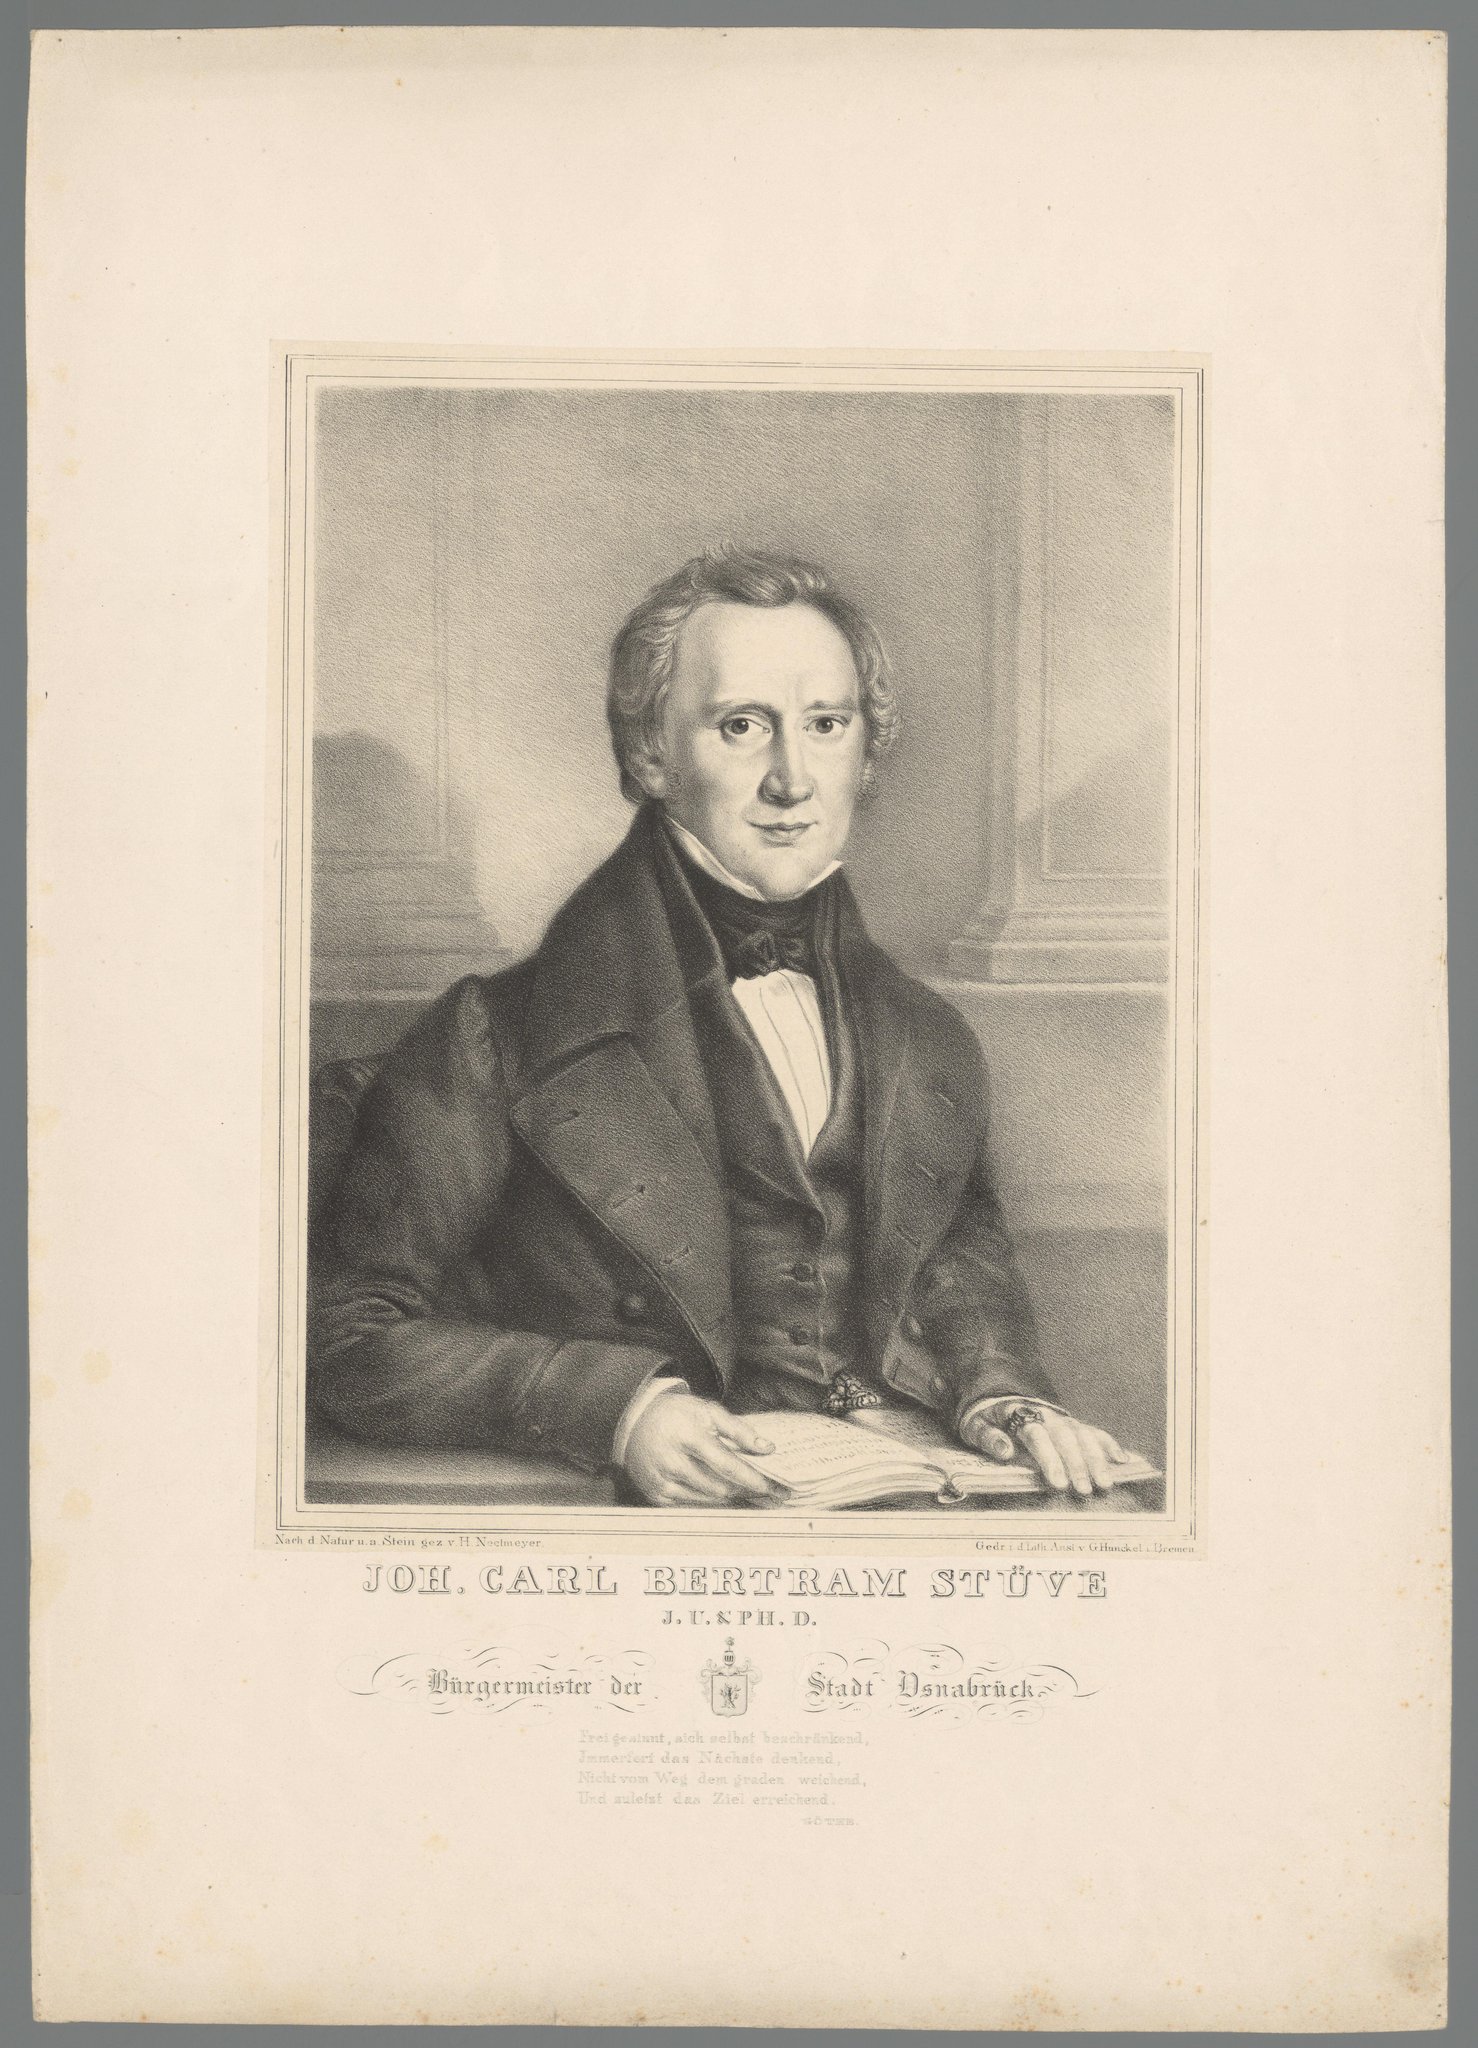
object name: print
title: Portret van Johann Karl Bertram Stüve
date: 1800-1839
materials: paper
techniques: lithograph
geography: bremen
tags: mayor, adult man, historical persons, book - mm - book open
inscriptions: collector's mark: Lugt 2228